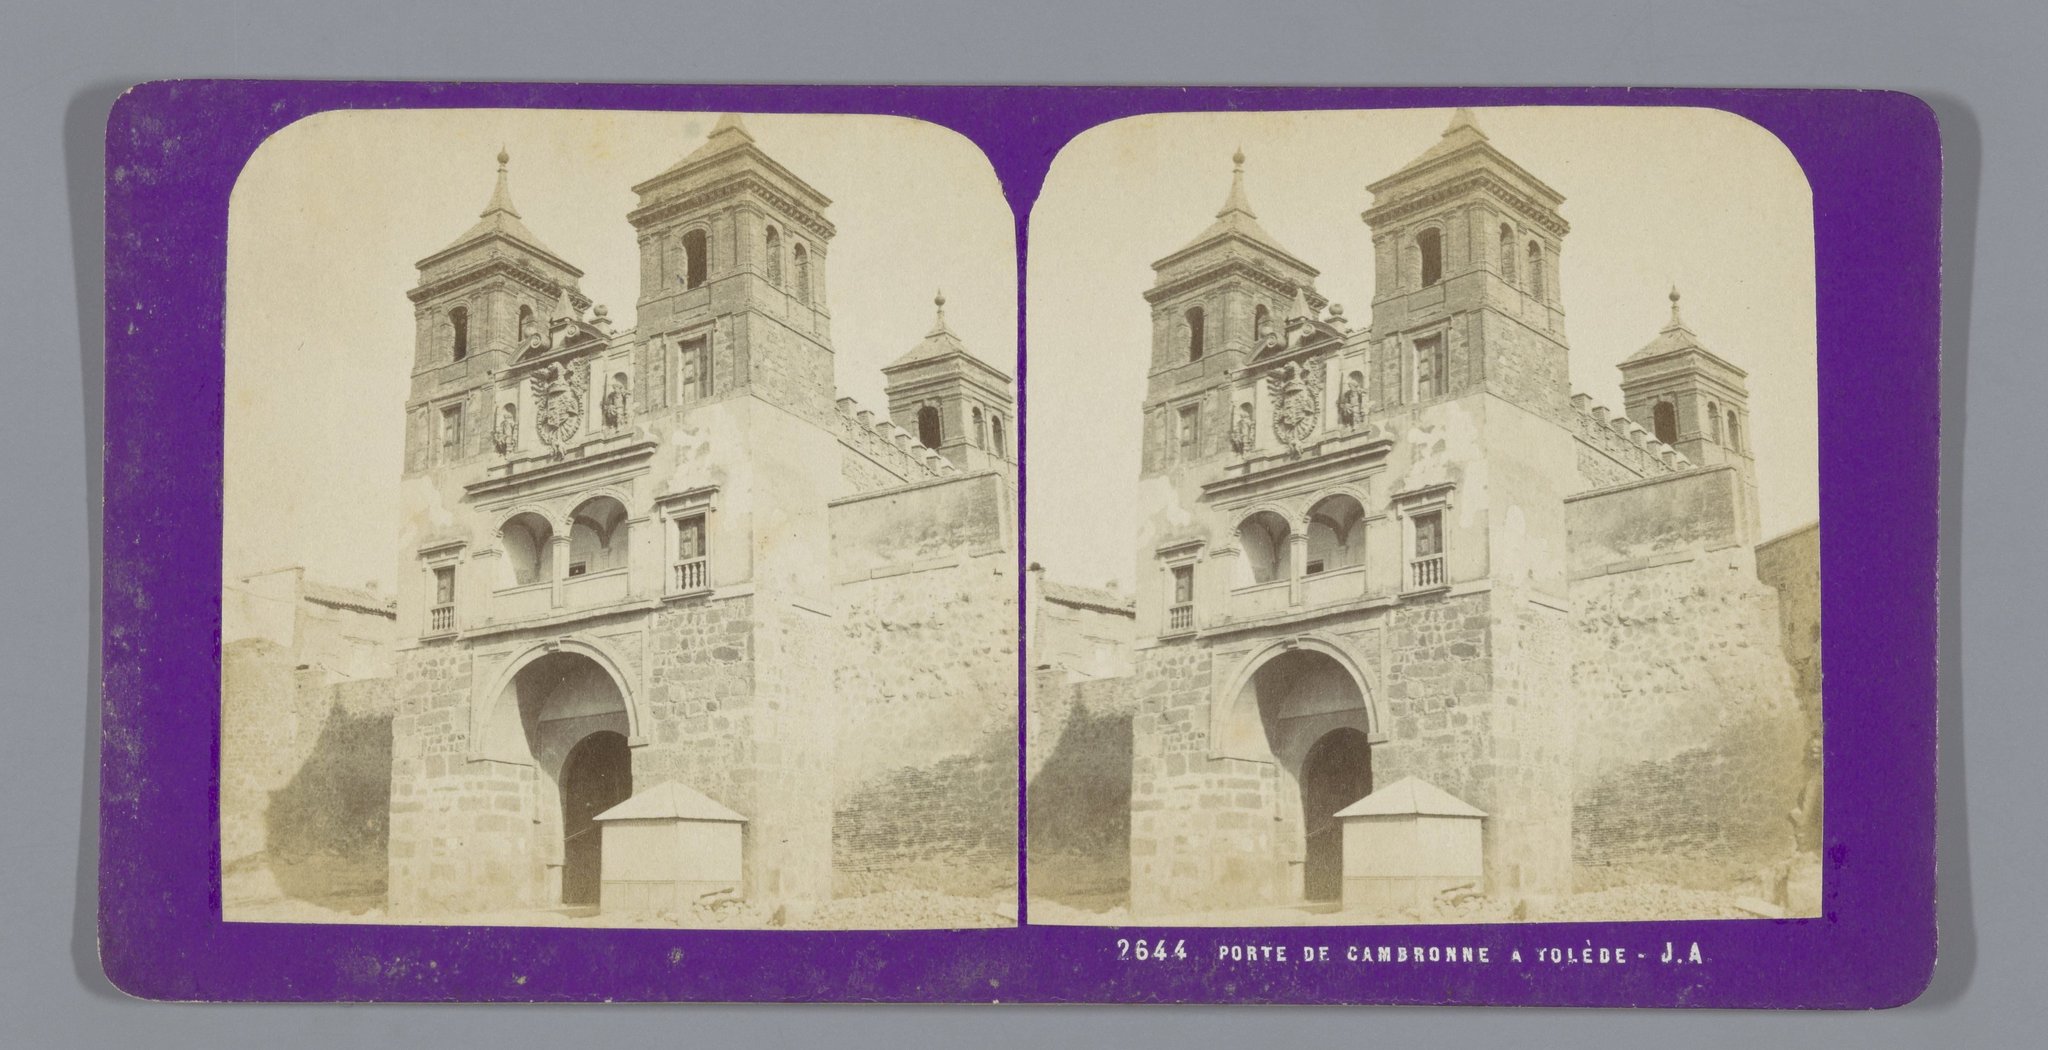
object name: stereograph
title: Exterieur van de Cambrónpoort te Toledo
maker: jean andrieu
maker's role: fotograaf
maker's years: 1816-1872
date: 1862-1876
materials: cardboard, photographic support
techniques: albumen print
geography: toledo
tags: façade (of house or building), city-gate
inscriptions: number: ‘2644.’